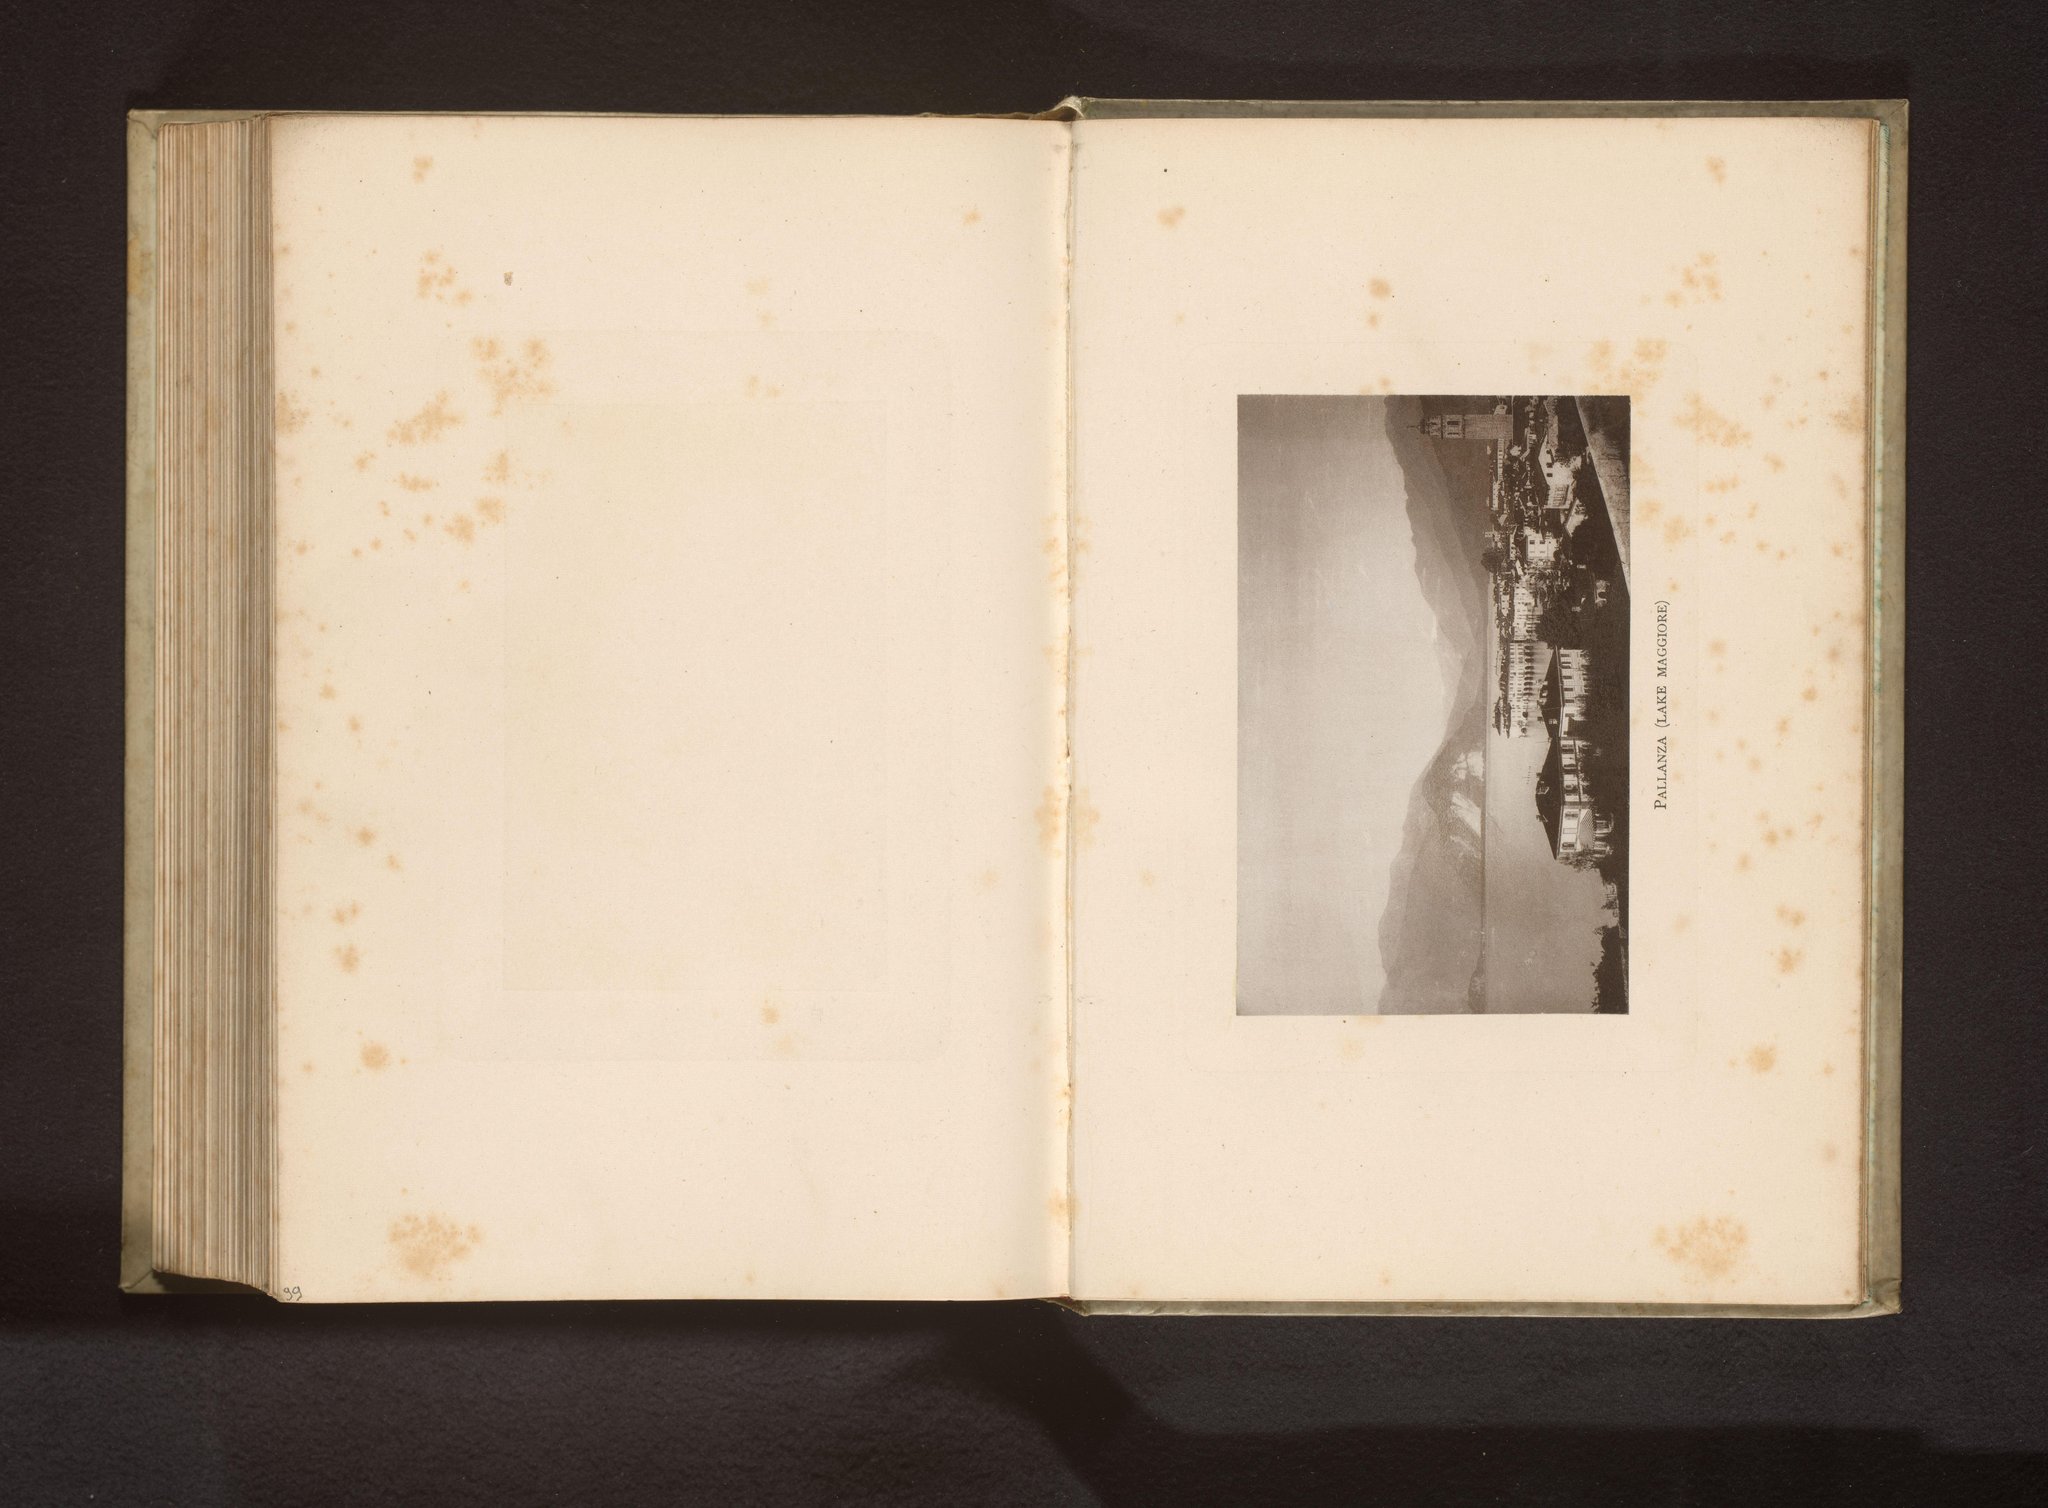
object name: page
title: Pallanza (Lake Maggiore)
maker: Anonymous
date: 1874-1884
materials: paper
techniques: photograph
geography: italy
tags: prospect of village, silhouette of village, lake, mountains